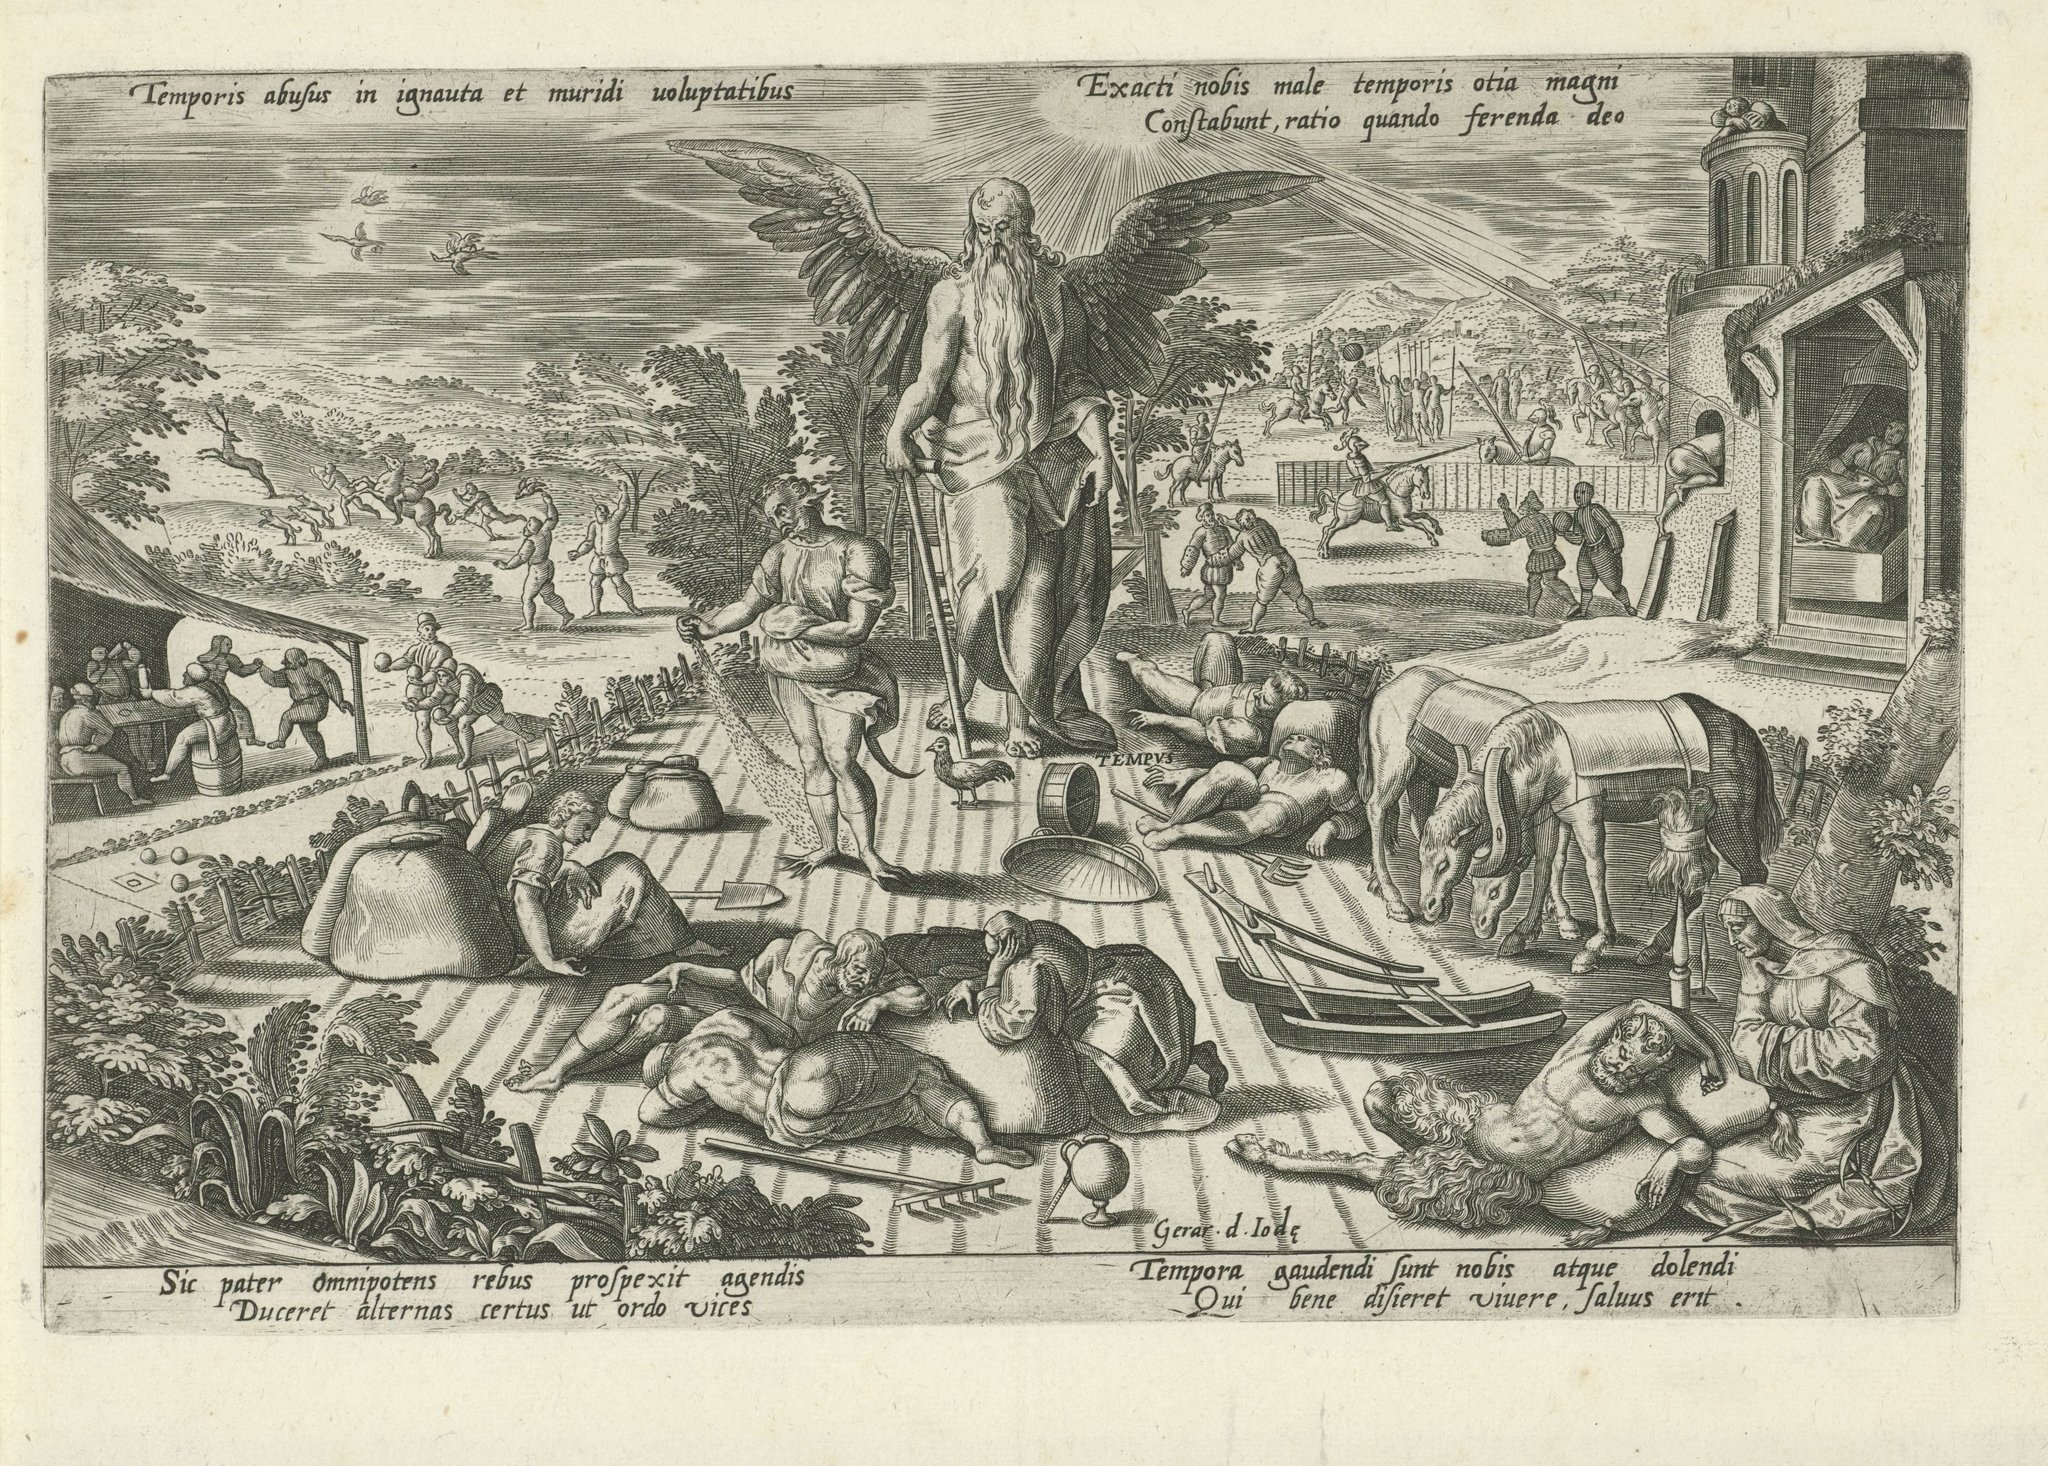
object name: print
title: Vader Tijd te midden van scènes met slecht gedrag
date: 1547-1591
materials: paper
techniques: engraving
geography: antwerp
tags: bad behaviour, father time, man with wings and scythe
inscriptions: collector's mark: Lugt 2228, collector's mark: Lugt 2760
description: In het midden de gevleugelde Vader Tijd, vergezeld door een haan. In het veld liggen arbeiders te slapen terwijl de duivel onkruid zaait (Mat. 13:25). Rechts op de voorgrond een slapende sater, liggend op een kussen in de schoot van een vrouw. Op de achtergrond diverse scènes met slecht gedrag: drinkende boeren, een jacht, een gevecht, een wedstrijd, een man klimt door een raam bij een vrouw in bed. In de marge een onderschrift in het Latijn. Prent uit een serie van vier met moraliserende allegorieën op de tijd.